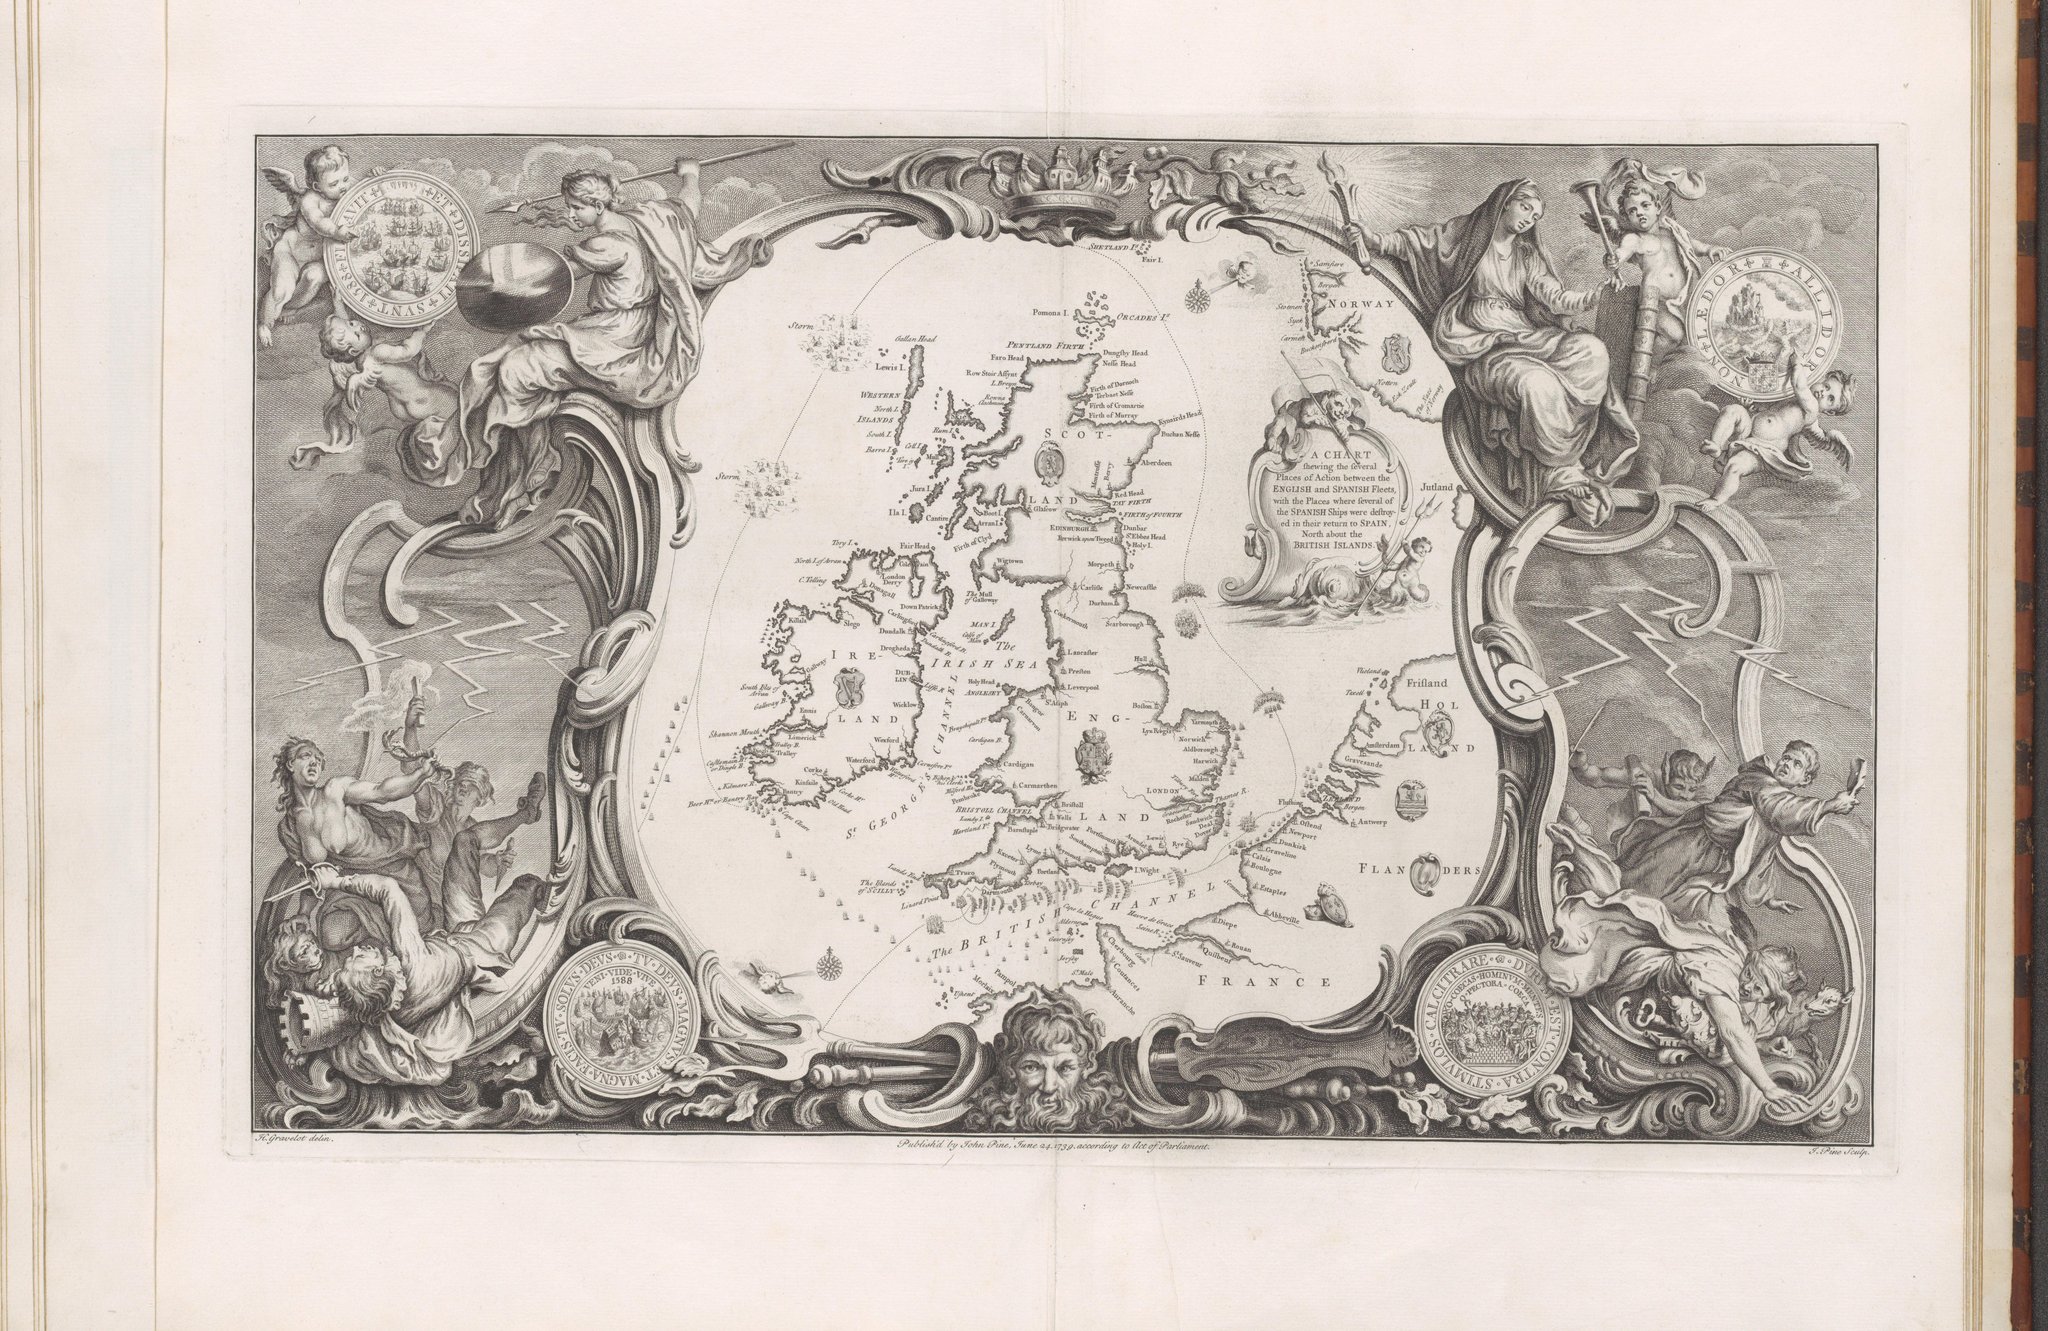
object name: album leaf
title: Kaart van Groot-Brittannië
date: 1739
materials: paper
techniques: engraving, etching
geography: london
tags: (story of) neptune (poseidon), personifications of countries, nations, states, districts, etc., 'superstitione' (ripa), envy; 'invidia' (ripa) ~ personification of one of the seven deadly sins, true religion vs. false religion, battle (+ naval force), medal (considered as a piece of sculpture, regardless of its specific function), medals and other marks of military honour, lightning, flash of lightning, thunderbolt, ignorance; 'ignoranza', 'ignoranza di tutte le cose', 'ignoranza in un ricco senza lettere' (ripa), dissimulation, hypocrisy; 'hippocresia', 'simulatione' (ripa), netherlands, great britain, france, norway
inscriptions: date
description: Kaart van Groot-Brittannië met links Ierland en rechts de kusten van Noorwegen, de Nederlanden en Frankrijk. Rechts een titelschild waarbij een leeuw met vaandel en een putto met drietand. In de kaart zijn verschillende wapenschilden geplaatst, waaronder die van de Engelse koningin Elizabeth I en de wapens van Holland en Zeeland. Op zee is de route aangegeven die de Spaanse Vloot in 1588 heeft afgelegd. Het geheel is gevat in een cartouche met bovenaan een Corona Navalis (scheepskroon) en onderaan het hoofd van Neptunus. Aan de linkerkant zit Brittannia. Haar donder en bliksem raakt Spanje (Castilië en León), Afgunst en Bijgeloof. Aan de rechterkant een verbeelding van het protestantisme als het Ware Geloof. Ze heeft een toorts en een grote bijbel als attributen en stuurt de bliksem af op Onwetendheid, Hypocrisie en het Pausdom. Verder worden de voor- en achterzijde van twee penningen of medaillons getoond. Bovenaan de Spaanse Vloot in een storm met op de andere zijde een kerk op een rots in een woeste zee, een beeld voor het Protestantse Geloof dat wordt aangevallen. Onderaan een penning over het vergaan van de Spaanse Vloot. Op de andere zijde zijn paus, kardinalen, bisschoppen, keizer en andere prinsen in beraad. Zij zijn geblinddoekt en hebben hun voeten op een vloer met pinnen of spijkers. De voorstelling maakt deel uit van een boek over de Spaanse Armada en de tapijten die daarover in opdracht van Charles Howard werden gemaakt.